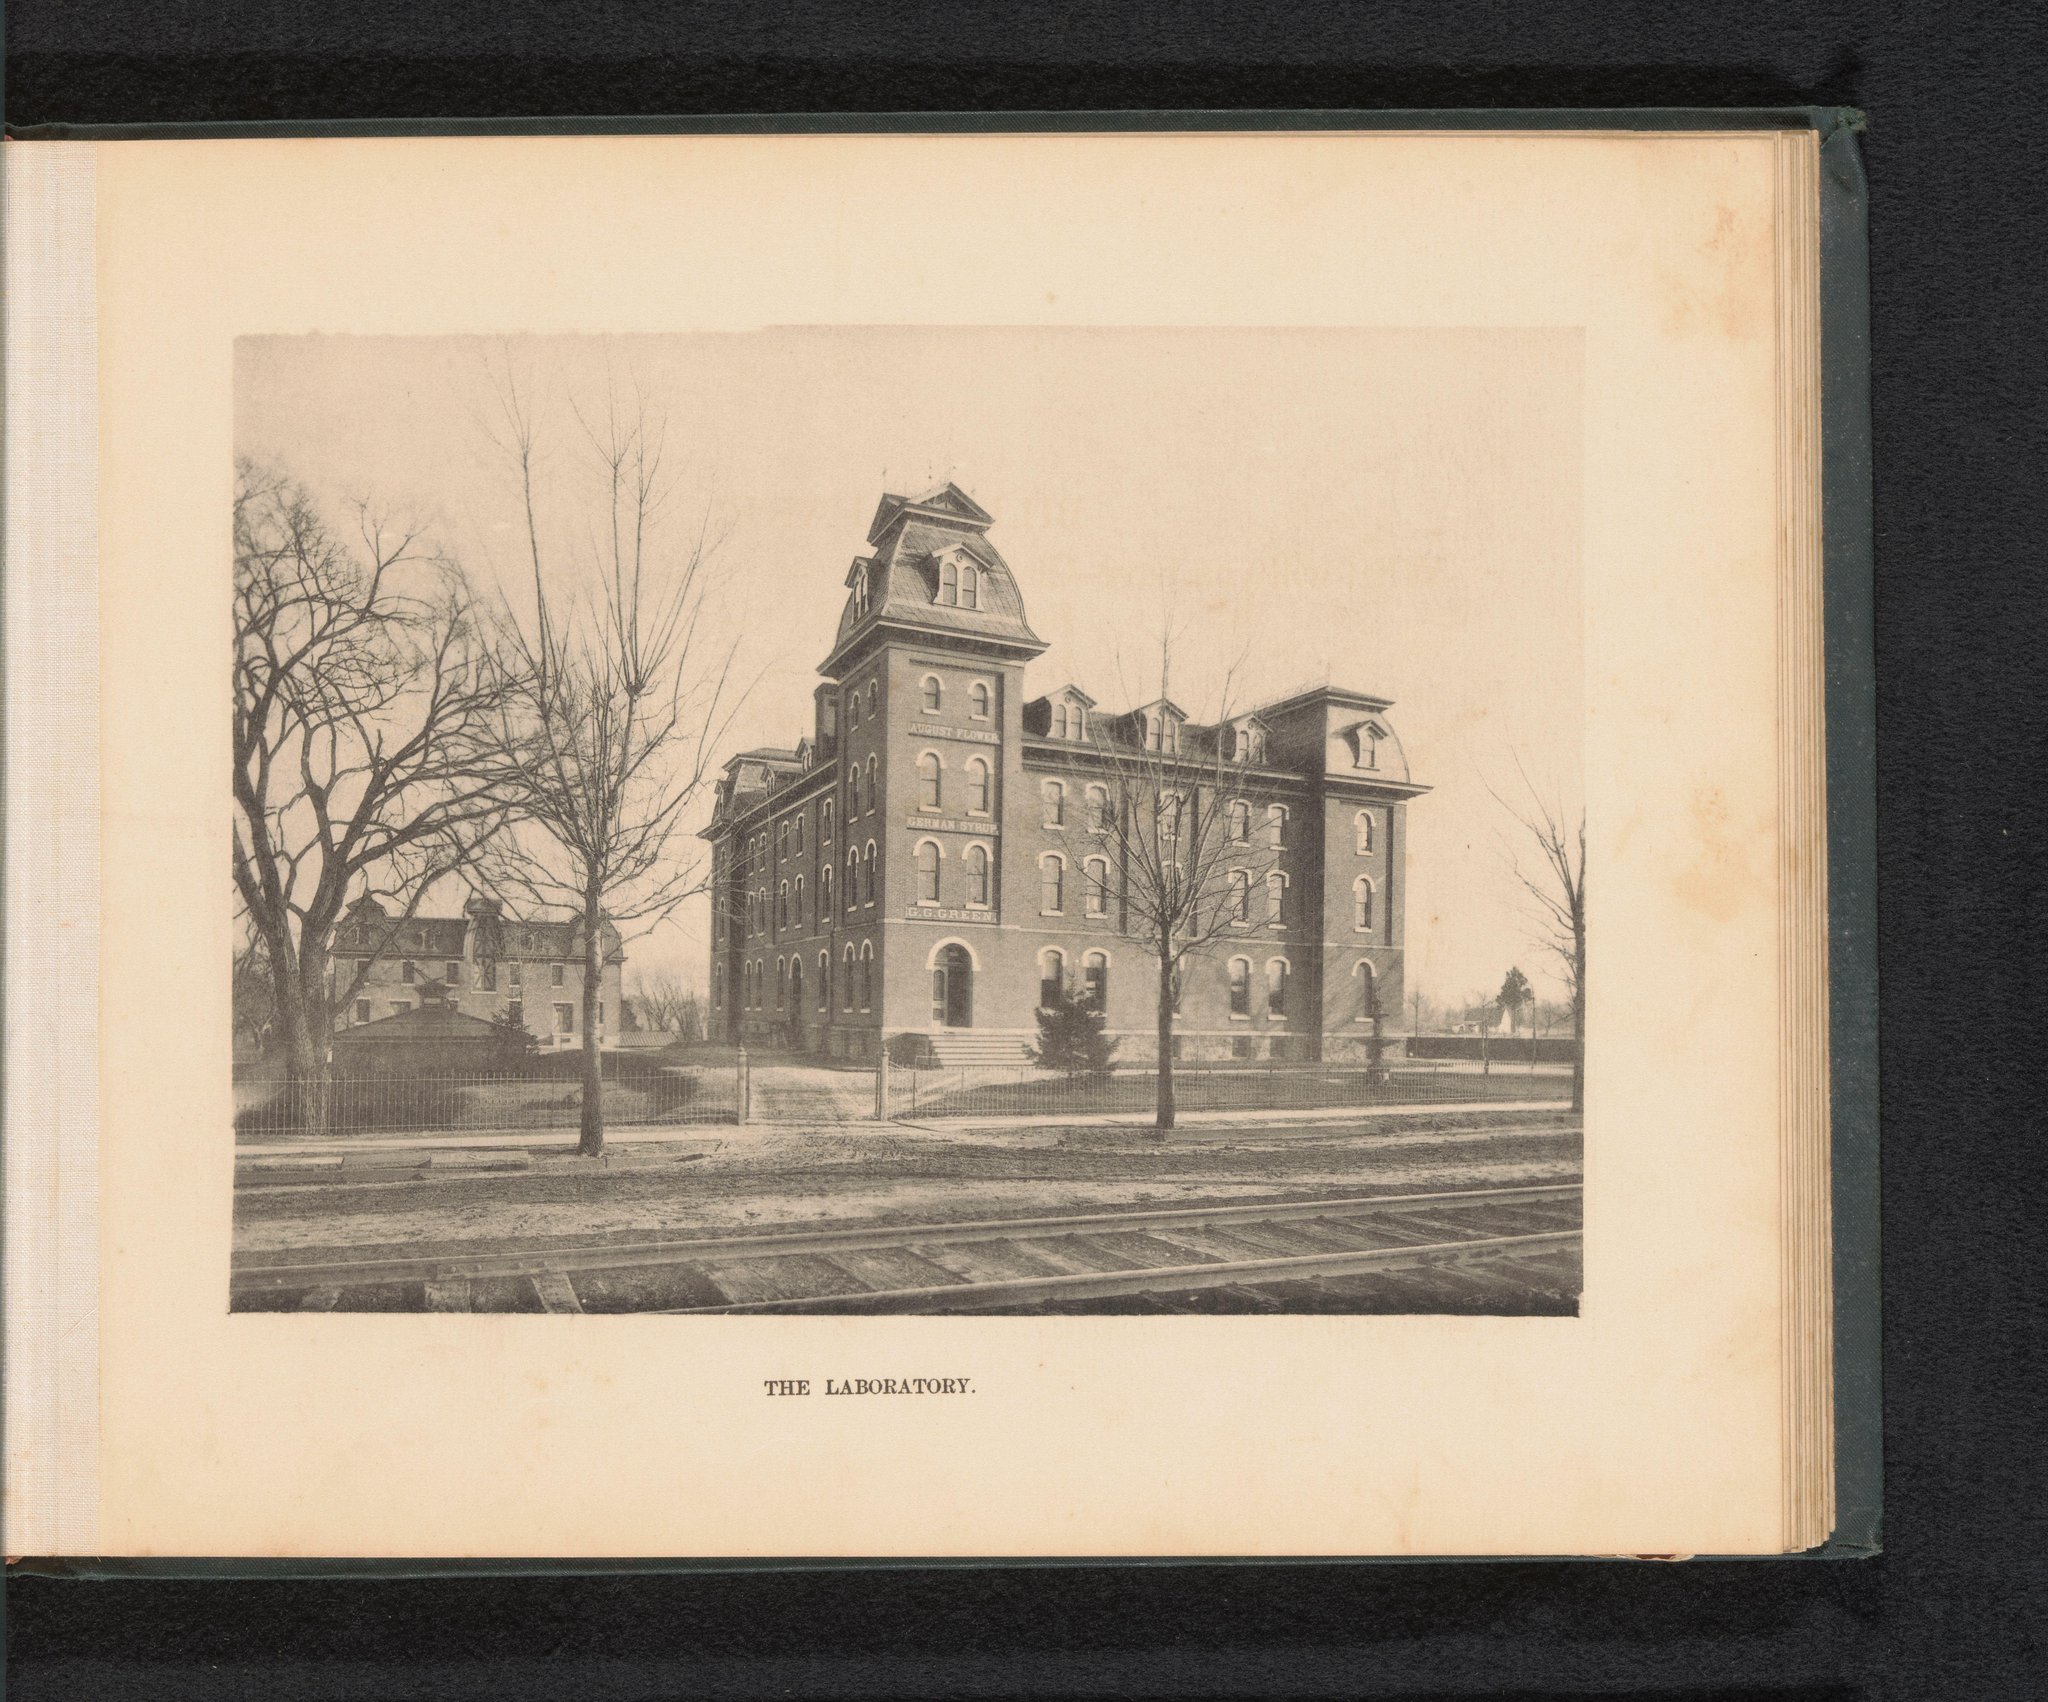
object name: photomechanical print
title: The Laboratoy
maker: Anonymous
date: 1879-1889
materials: paper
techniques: photograph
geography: woodbury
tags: laboratory